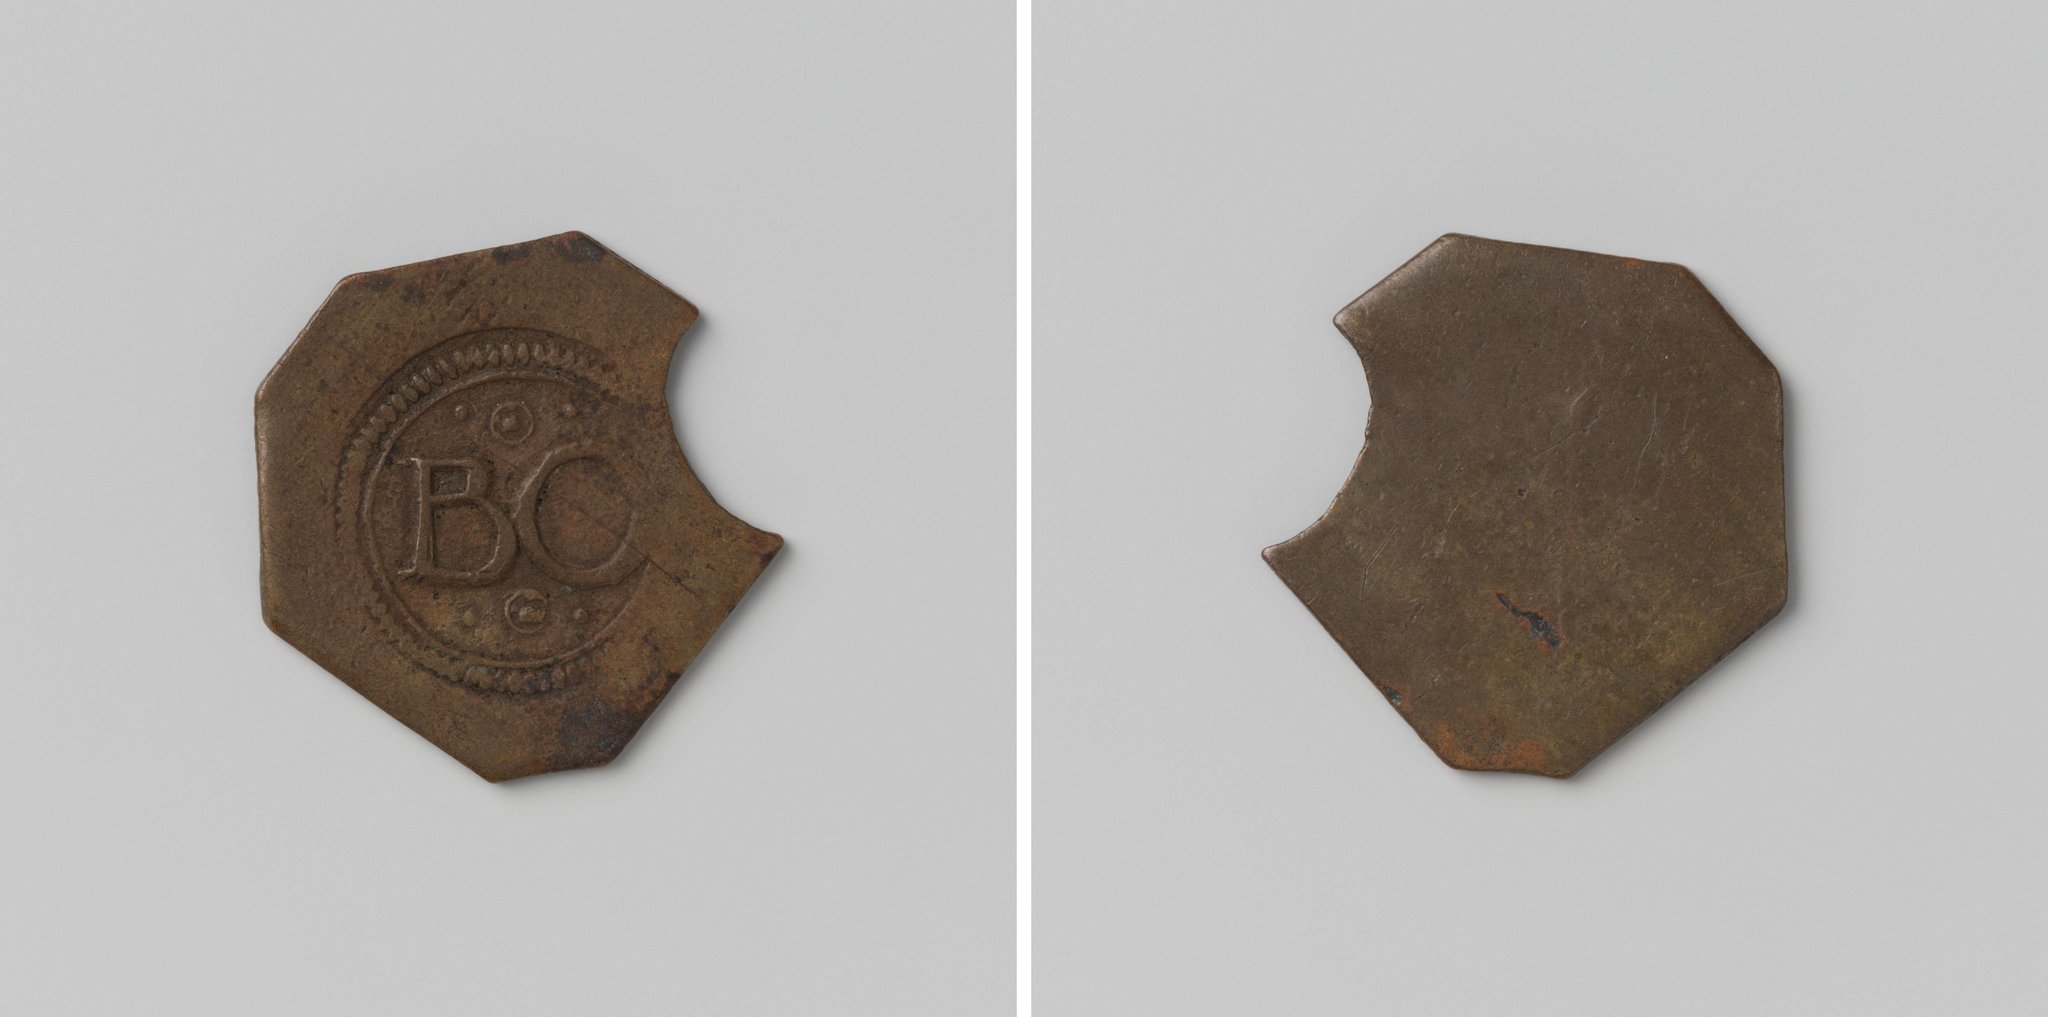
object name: alms token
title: Armenpenning met opschrift BO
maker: Anonymous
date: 1600-1800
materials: brass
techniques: striking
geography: amsterdam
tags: amsterdam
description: Enkelzijdige messing achthoekige armenpenning, waar aan rechterkant halfrond stuk is uitgeknipt. Voorzijde: in ronde parelcirkel: monogram van letters B en O. Keerzijde: blanco.